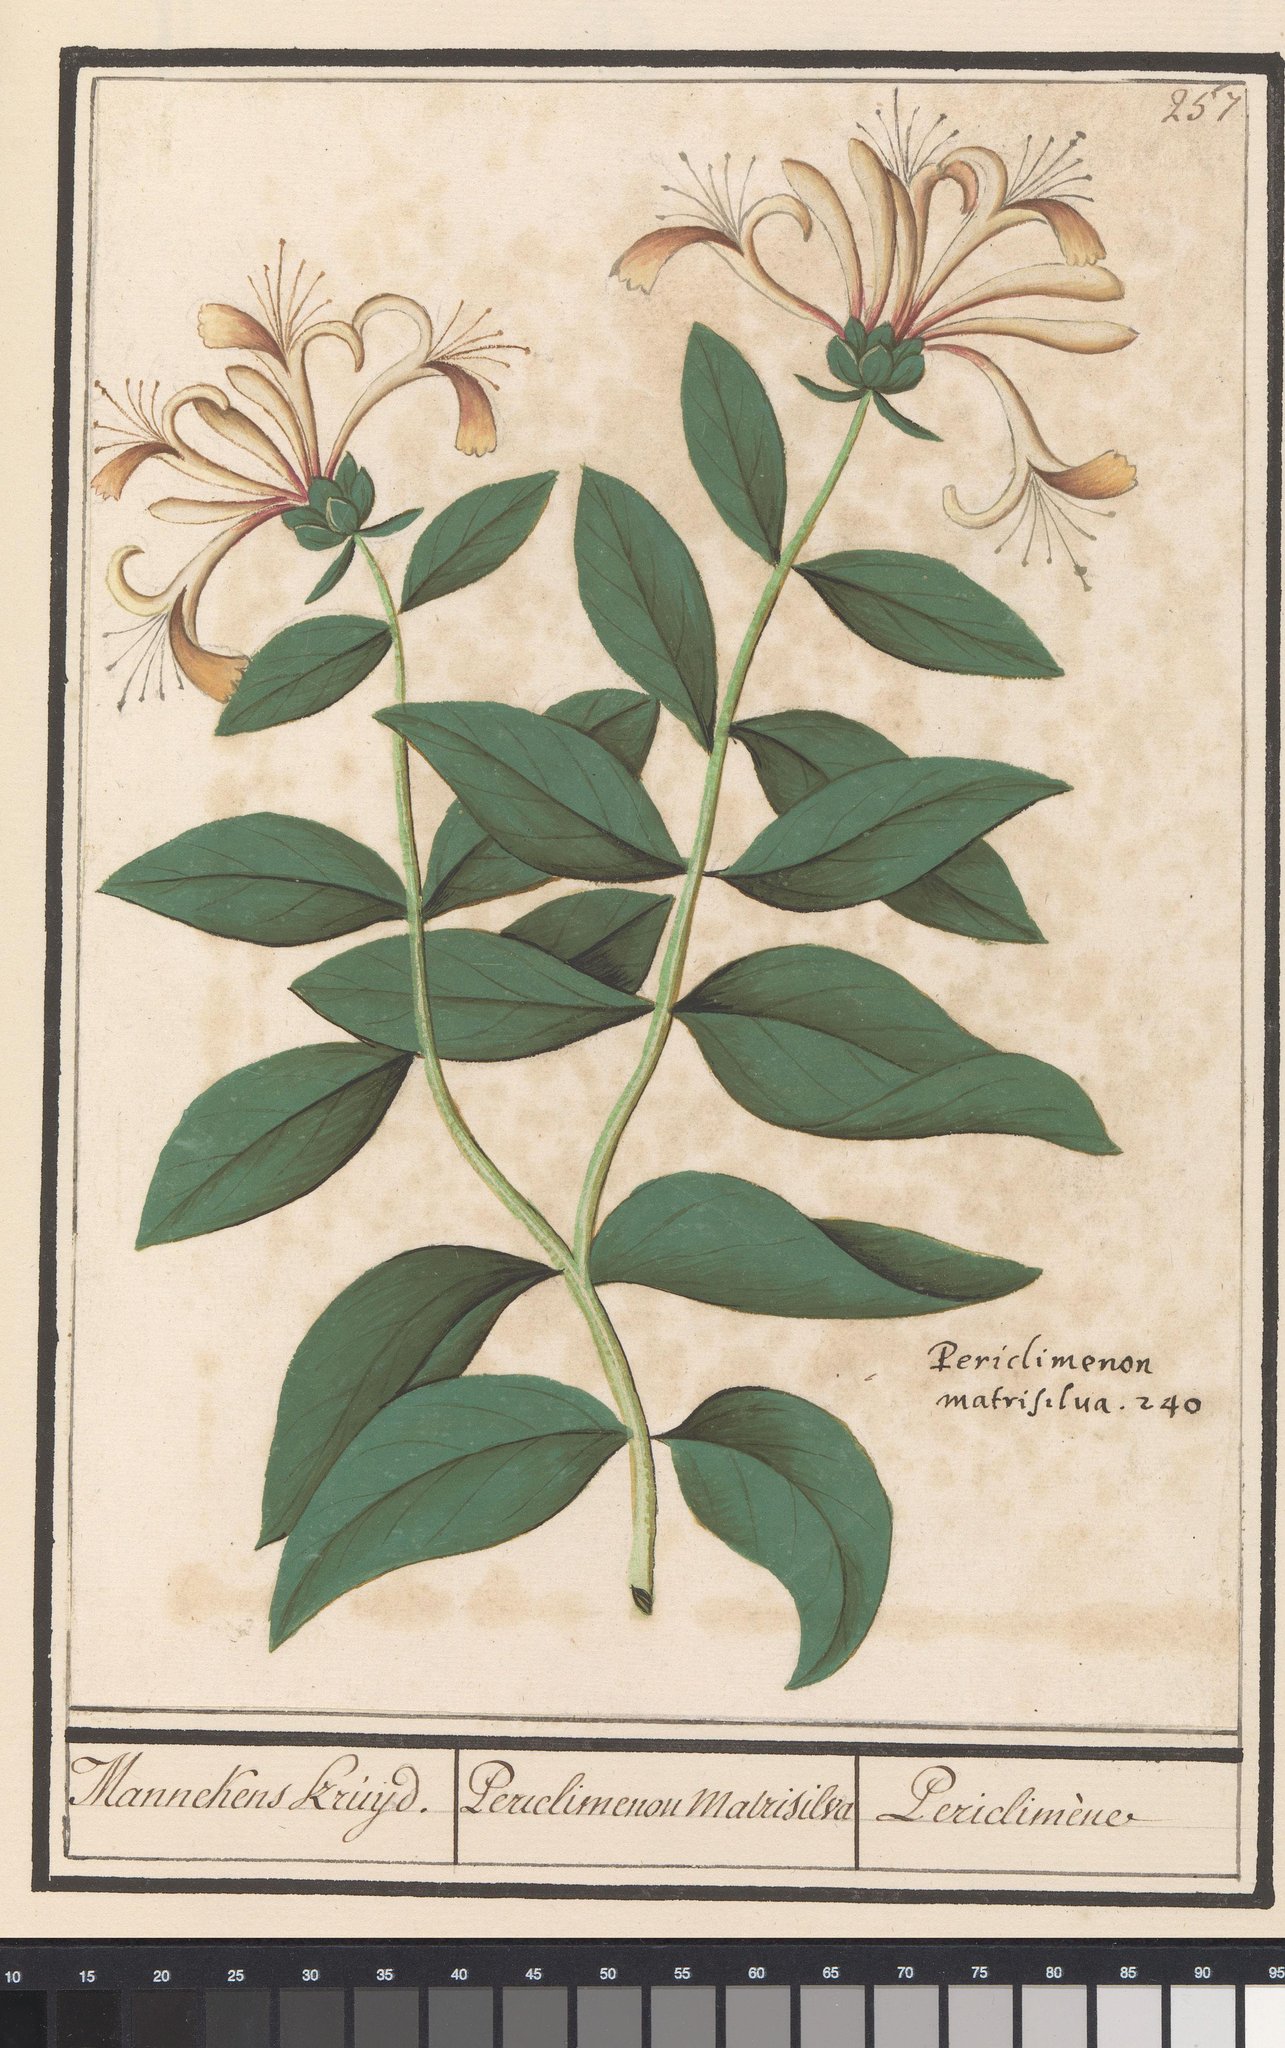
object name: drawing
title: Tuinkamperfoelie of gewone kamperfoelie (Lonicera caprifolium)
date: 1596-1610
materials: chalk, paint, ink, paper, watercolor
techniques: brush, pen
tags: flowers: honeysuckle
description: Kamperfoelie. Genummerd rechtsboven: 257. Onderaan de Latijnse naam. Onderdeel van het derde album met tekeningen van bloemen en planten. Tiende van twaalf albums met tekeningen van dieren, vogels en planten bekend rond 1600, gemaakt in opdracht van keizer Rudolf II. Met toelichting in Nederlands, Latijn en Frans.